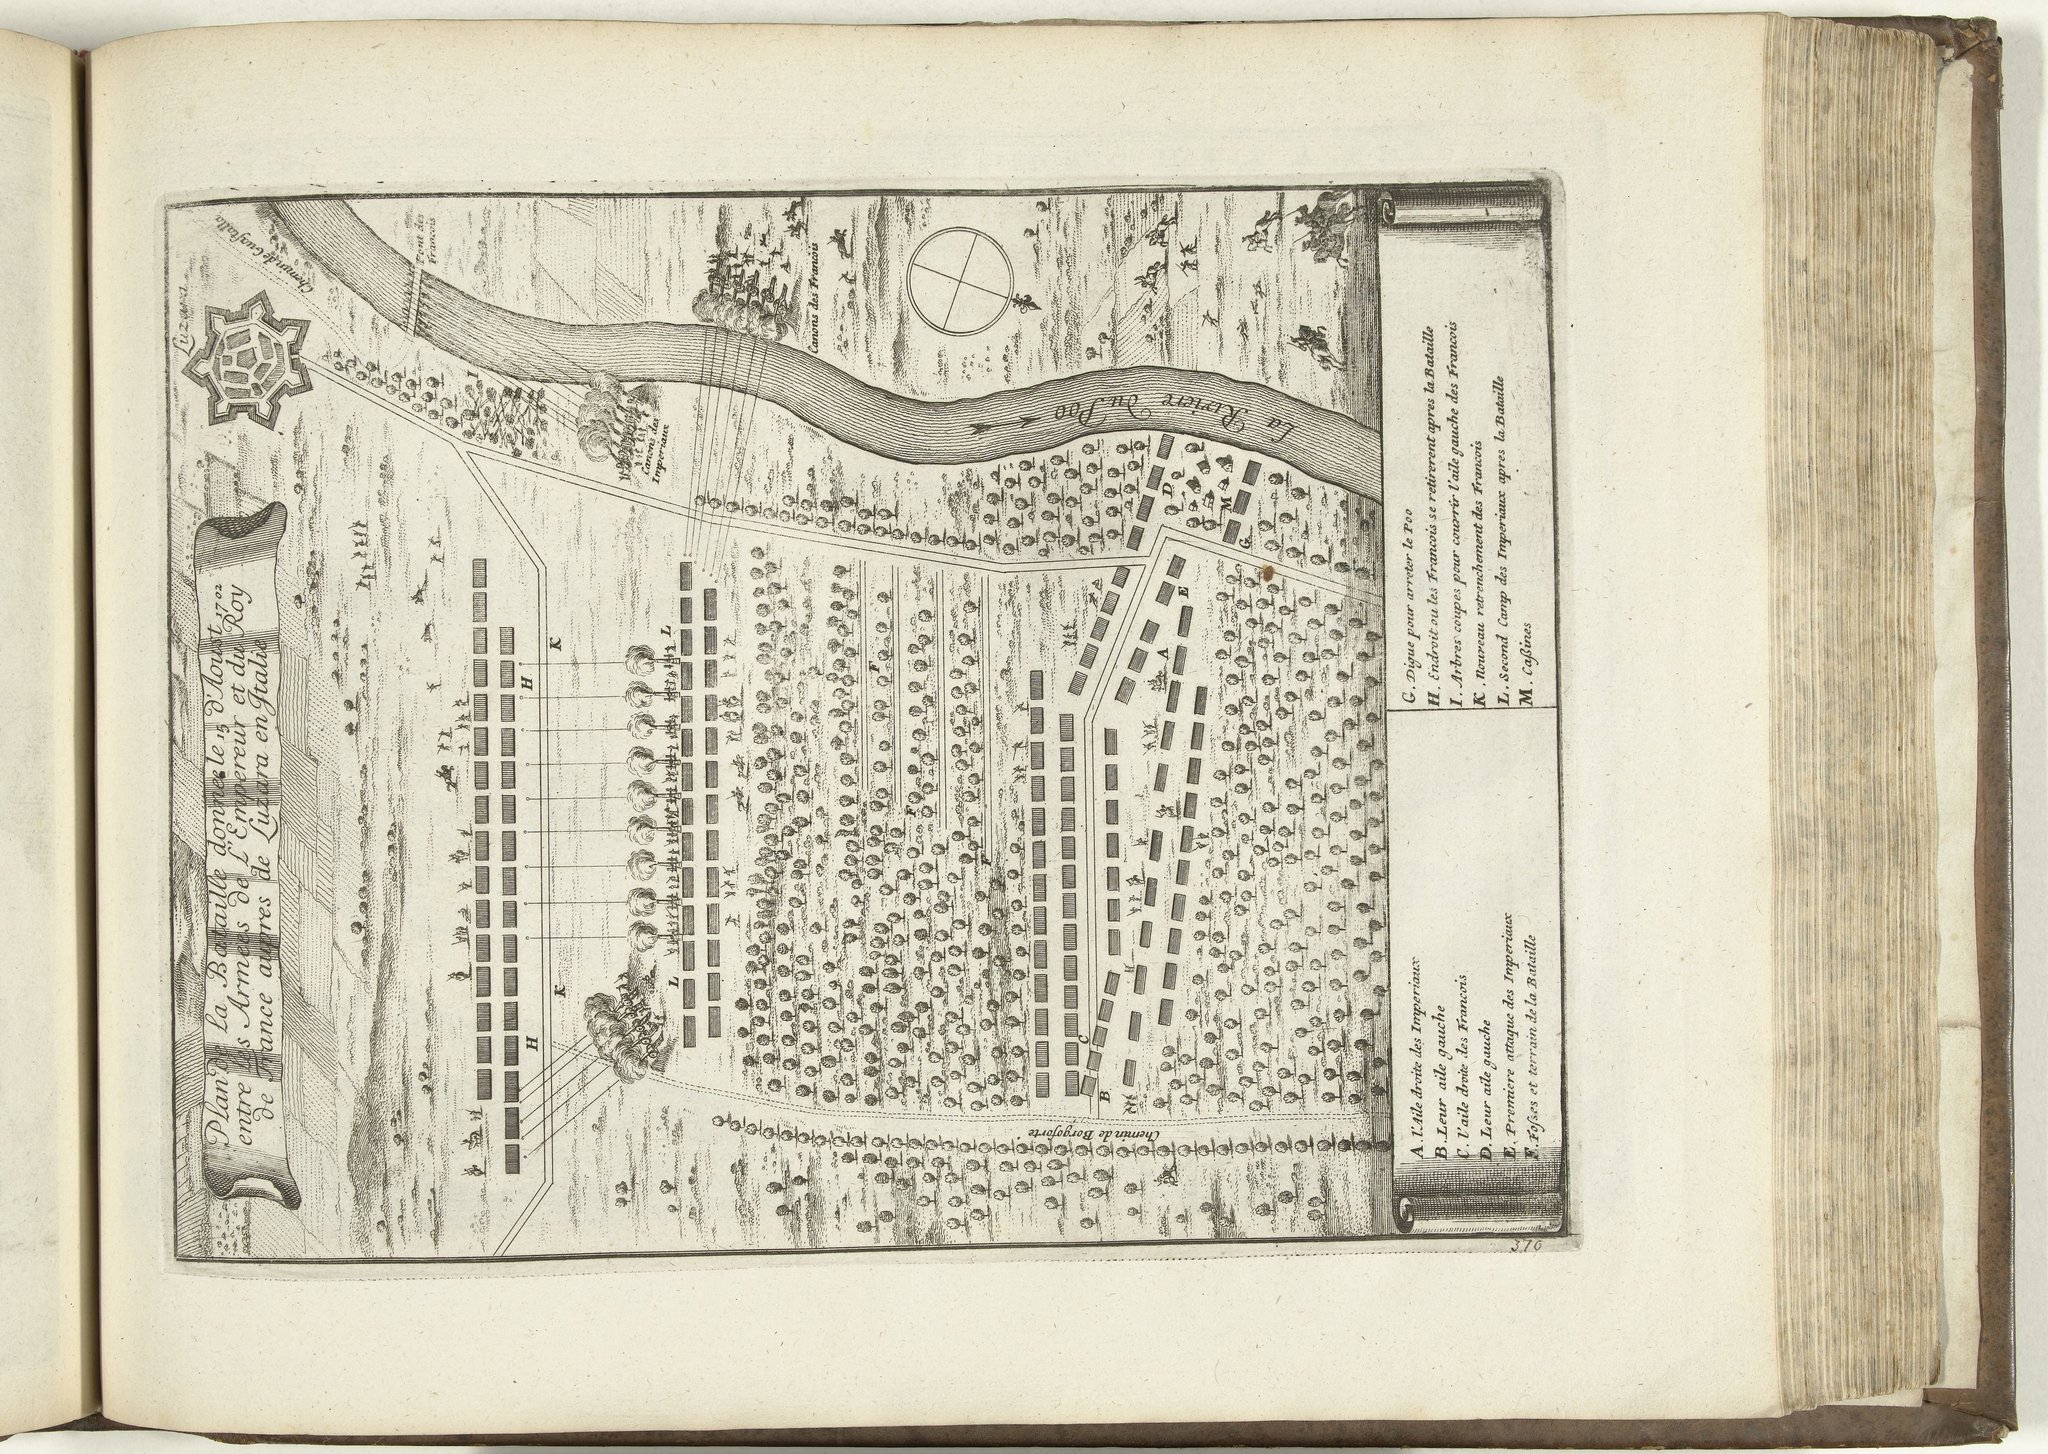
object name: print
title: Plan de la Bataille donnee le 15 d'Aoust 1702 entre les Armees de l'Empereur et du Roy de France aupres de Luzara en Italie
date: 1726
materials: paper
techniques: etching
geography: leiden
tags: battle (+ land forces)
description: Plan met de slagordes van de Franse en geallieerde troepen tijdens de slag bij Luzzara op 15 augustus 1702. Plaat nr. 370 in deel XV van het prentwerk: Les Forces de l'Europe, Asie, Afrique et Amerique ... Comme aussi les Cartes des Côtes de France et d'Espagne uit 1726, dit tweede deel met 271 met de hand genummerde platen van vermaarde sterke steden en vestingen in het kader van de Spaanse Successieoorlog 1701-1713. Voor het merendeel zijn deze platen gekopieerd naar de anonieme Franse platen van vermaarde sterke steden en vestingen: in Les forces de l'Europe en in: Le theatre de la guerre, dans les Pays-Bas, beide oorspronkelijk uitgegeven door Nicolas de Fer te Parijs (1693-1697) in het kader van de Negenjarige Oorlog. Titel en opschriften in het Frans.